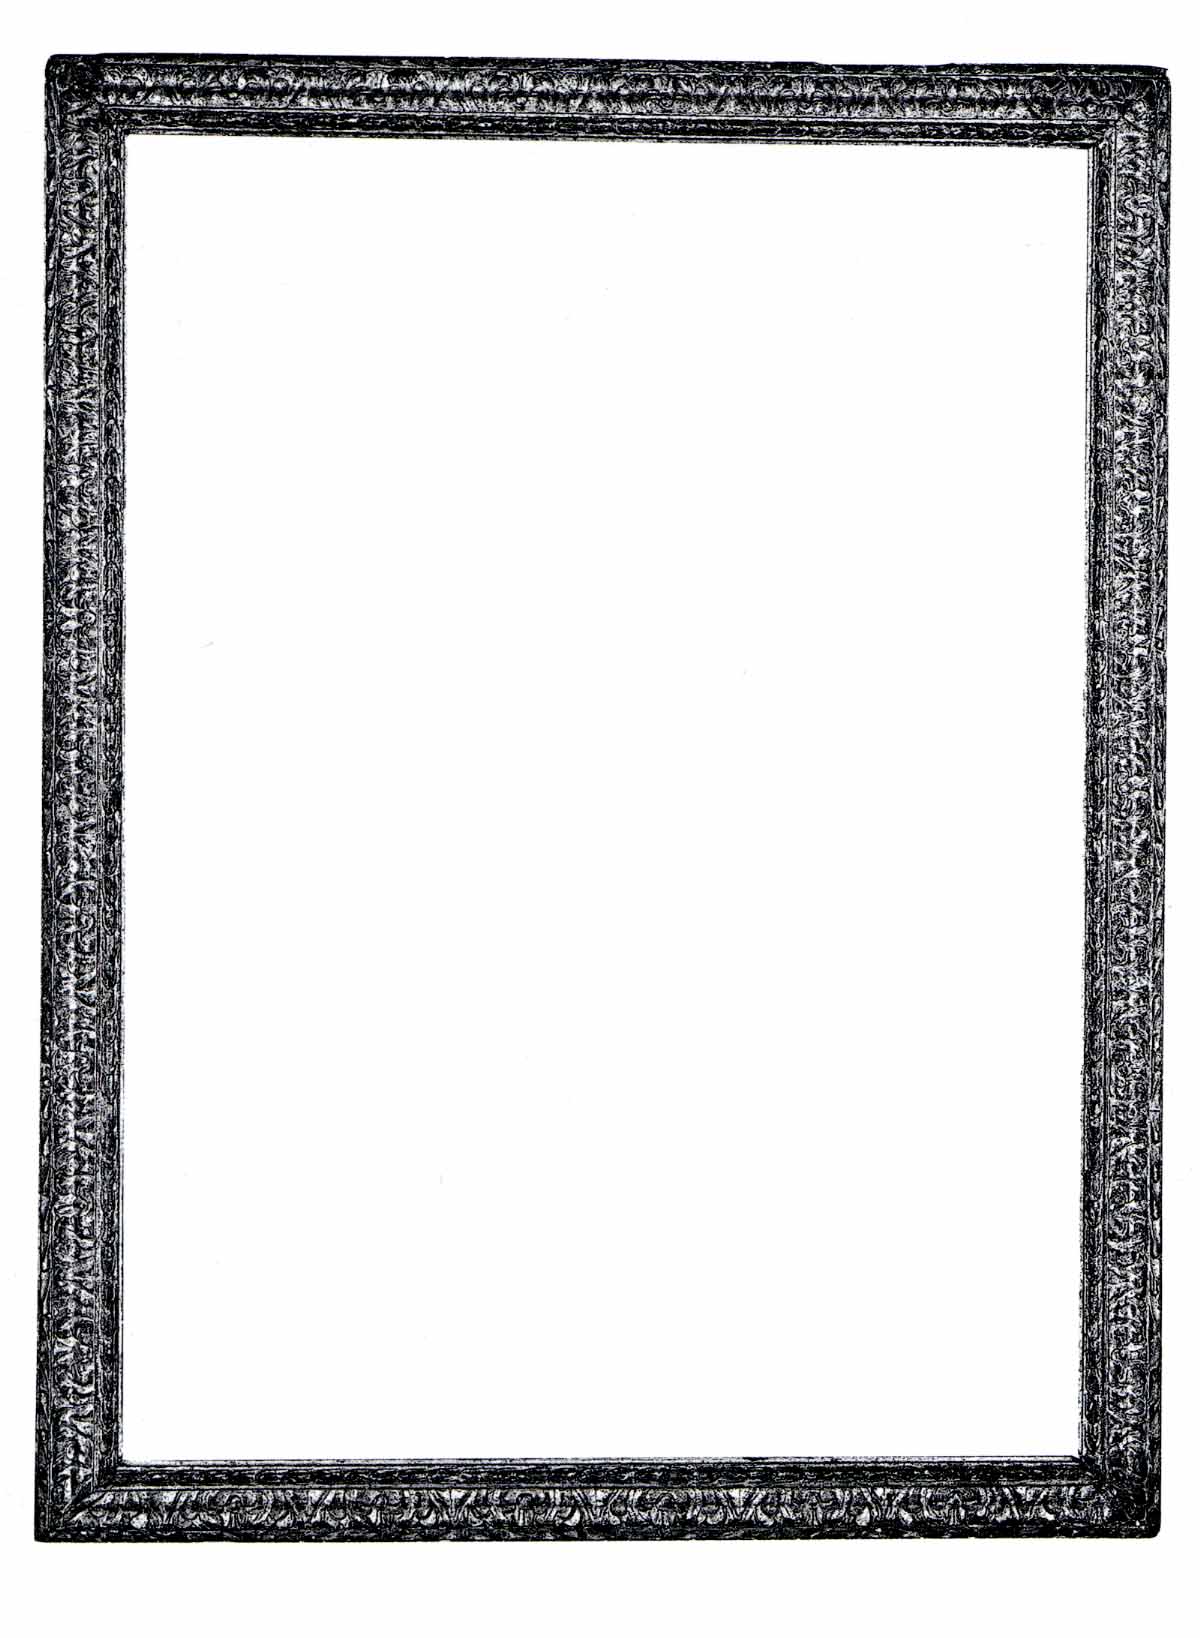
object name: frame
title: Reverse ogee frame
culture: italian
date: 1645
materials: gilt, wood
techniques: carving